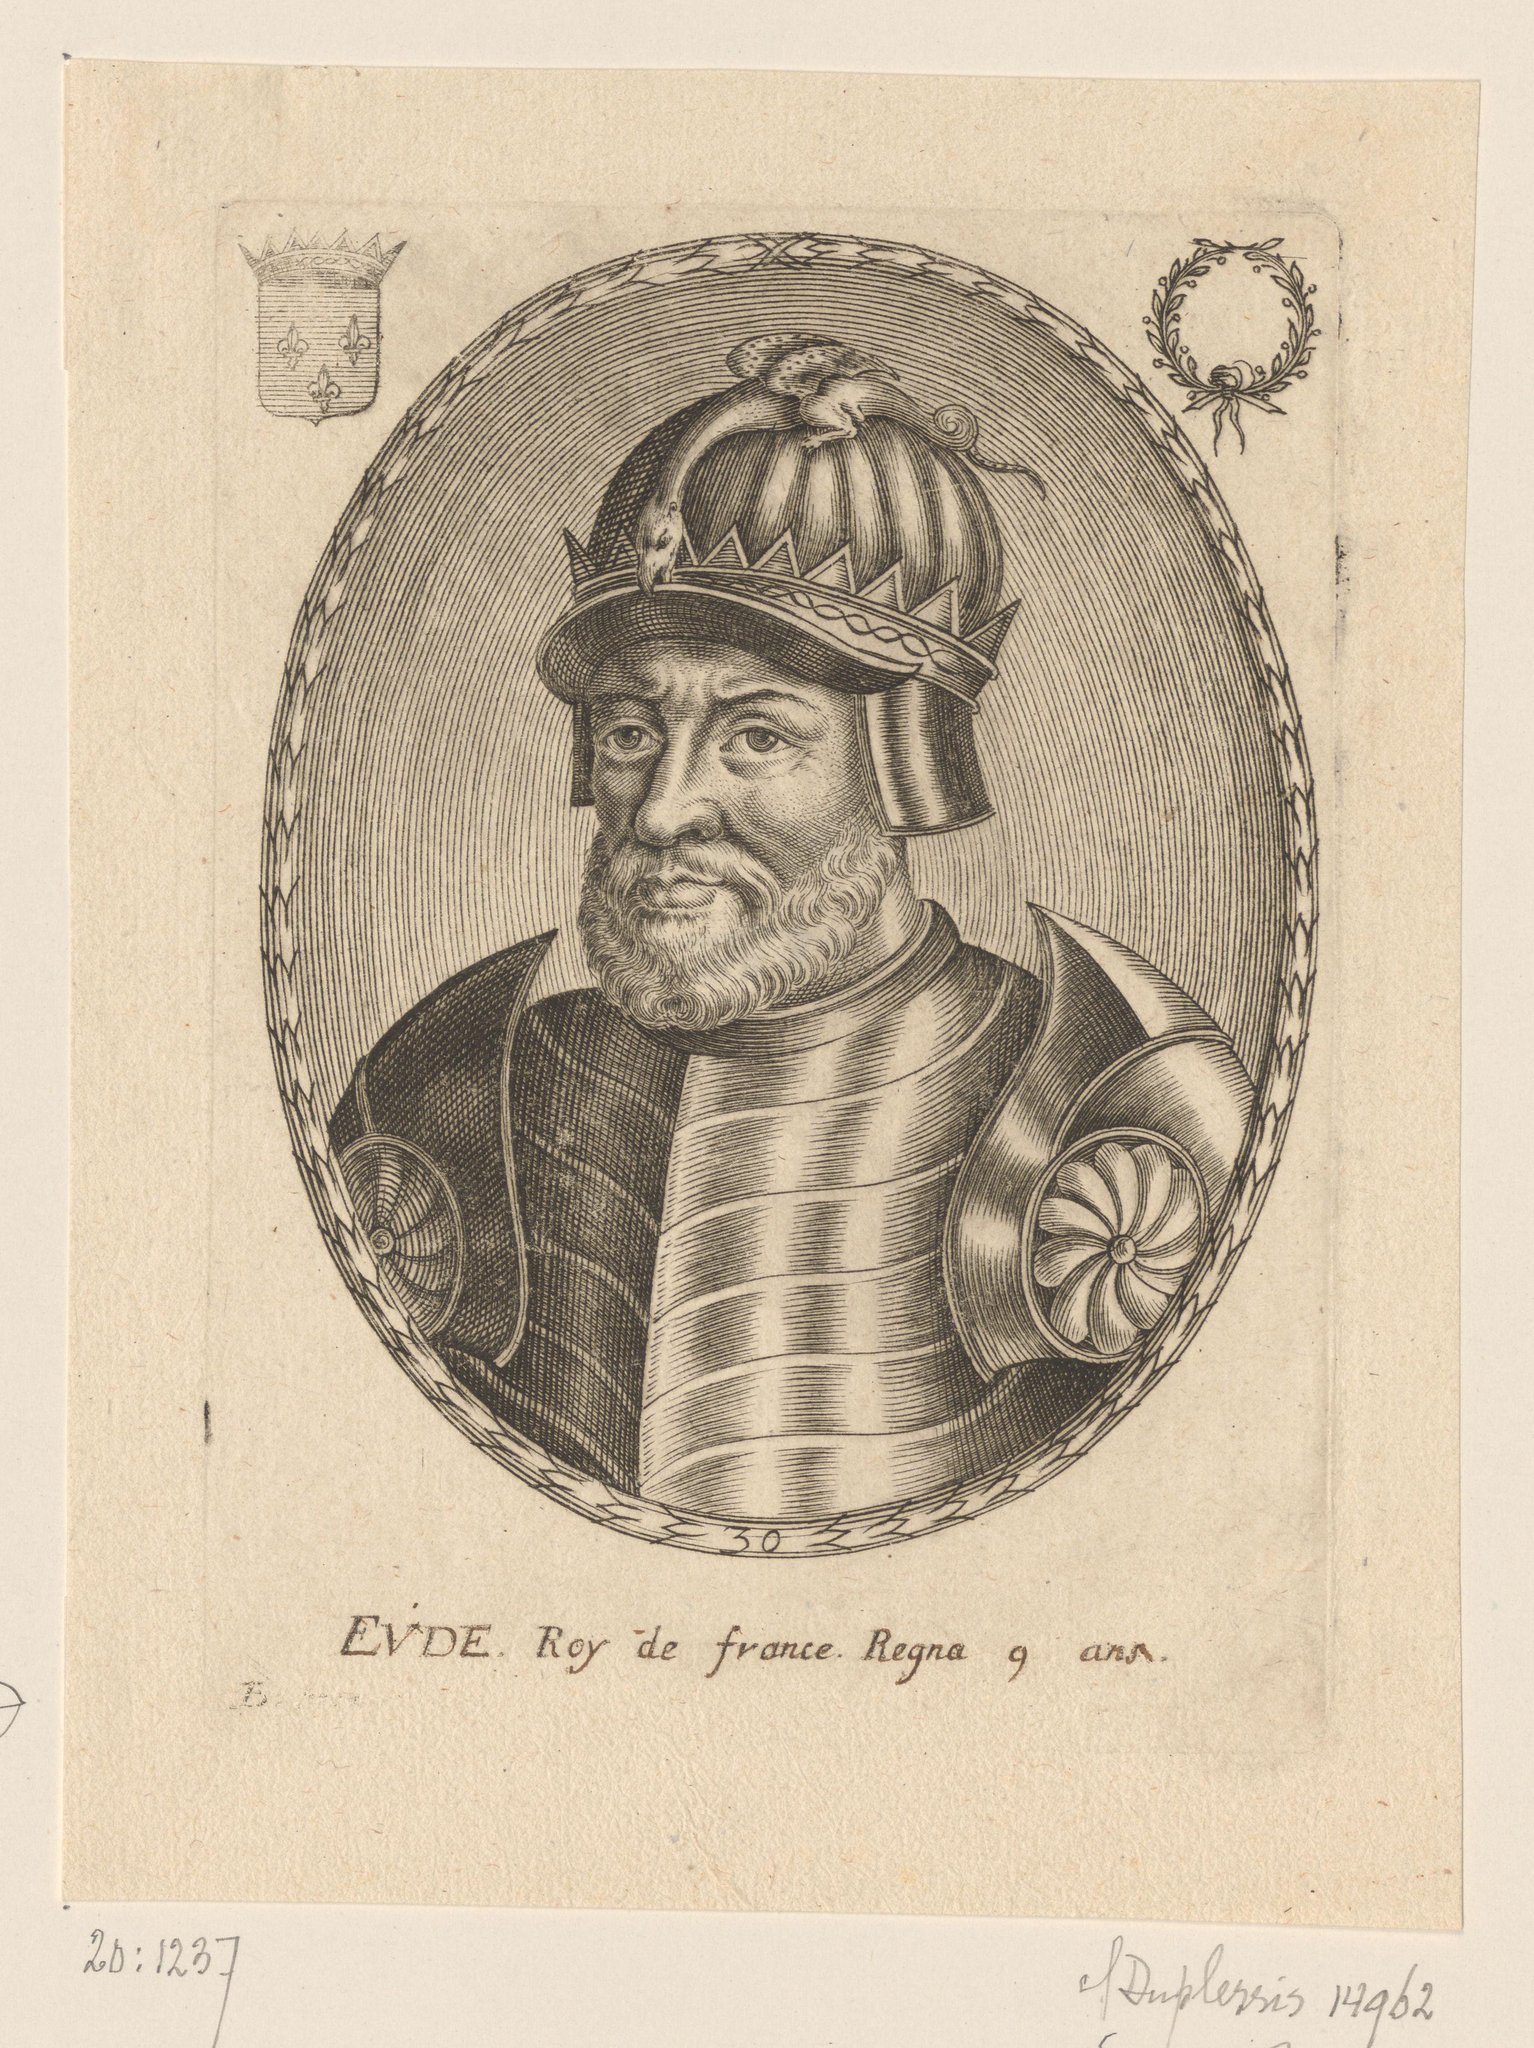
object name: print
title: Portretten uitgegeven door Balthazar Moncornet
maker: balthazar moncornet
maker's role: print maker, publisher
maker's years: 1600-1668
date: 1652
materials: paper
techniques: engraving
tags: historical persons, dragon, ornament ~ festoon, garland, armorial bearing, heraldry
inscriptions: collector's mark: Lugt 2228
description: Prent hoort vermoedelijk bij een prentenserie uitgegeven door Moncornet, bekend onder de naam Recueil de portraits des rois, princes et seigneurs français et étrangers (...), zie Van Someren, 1888.